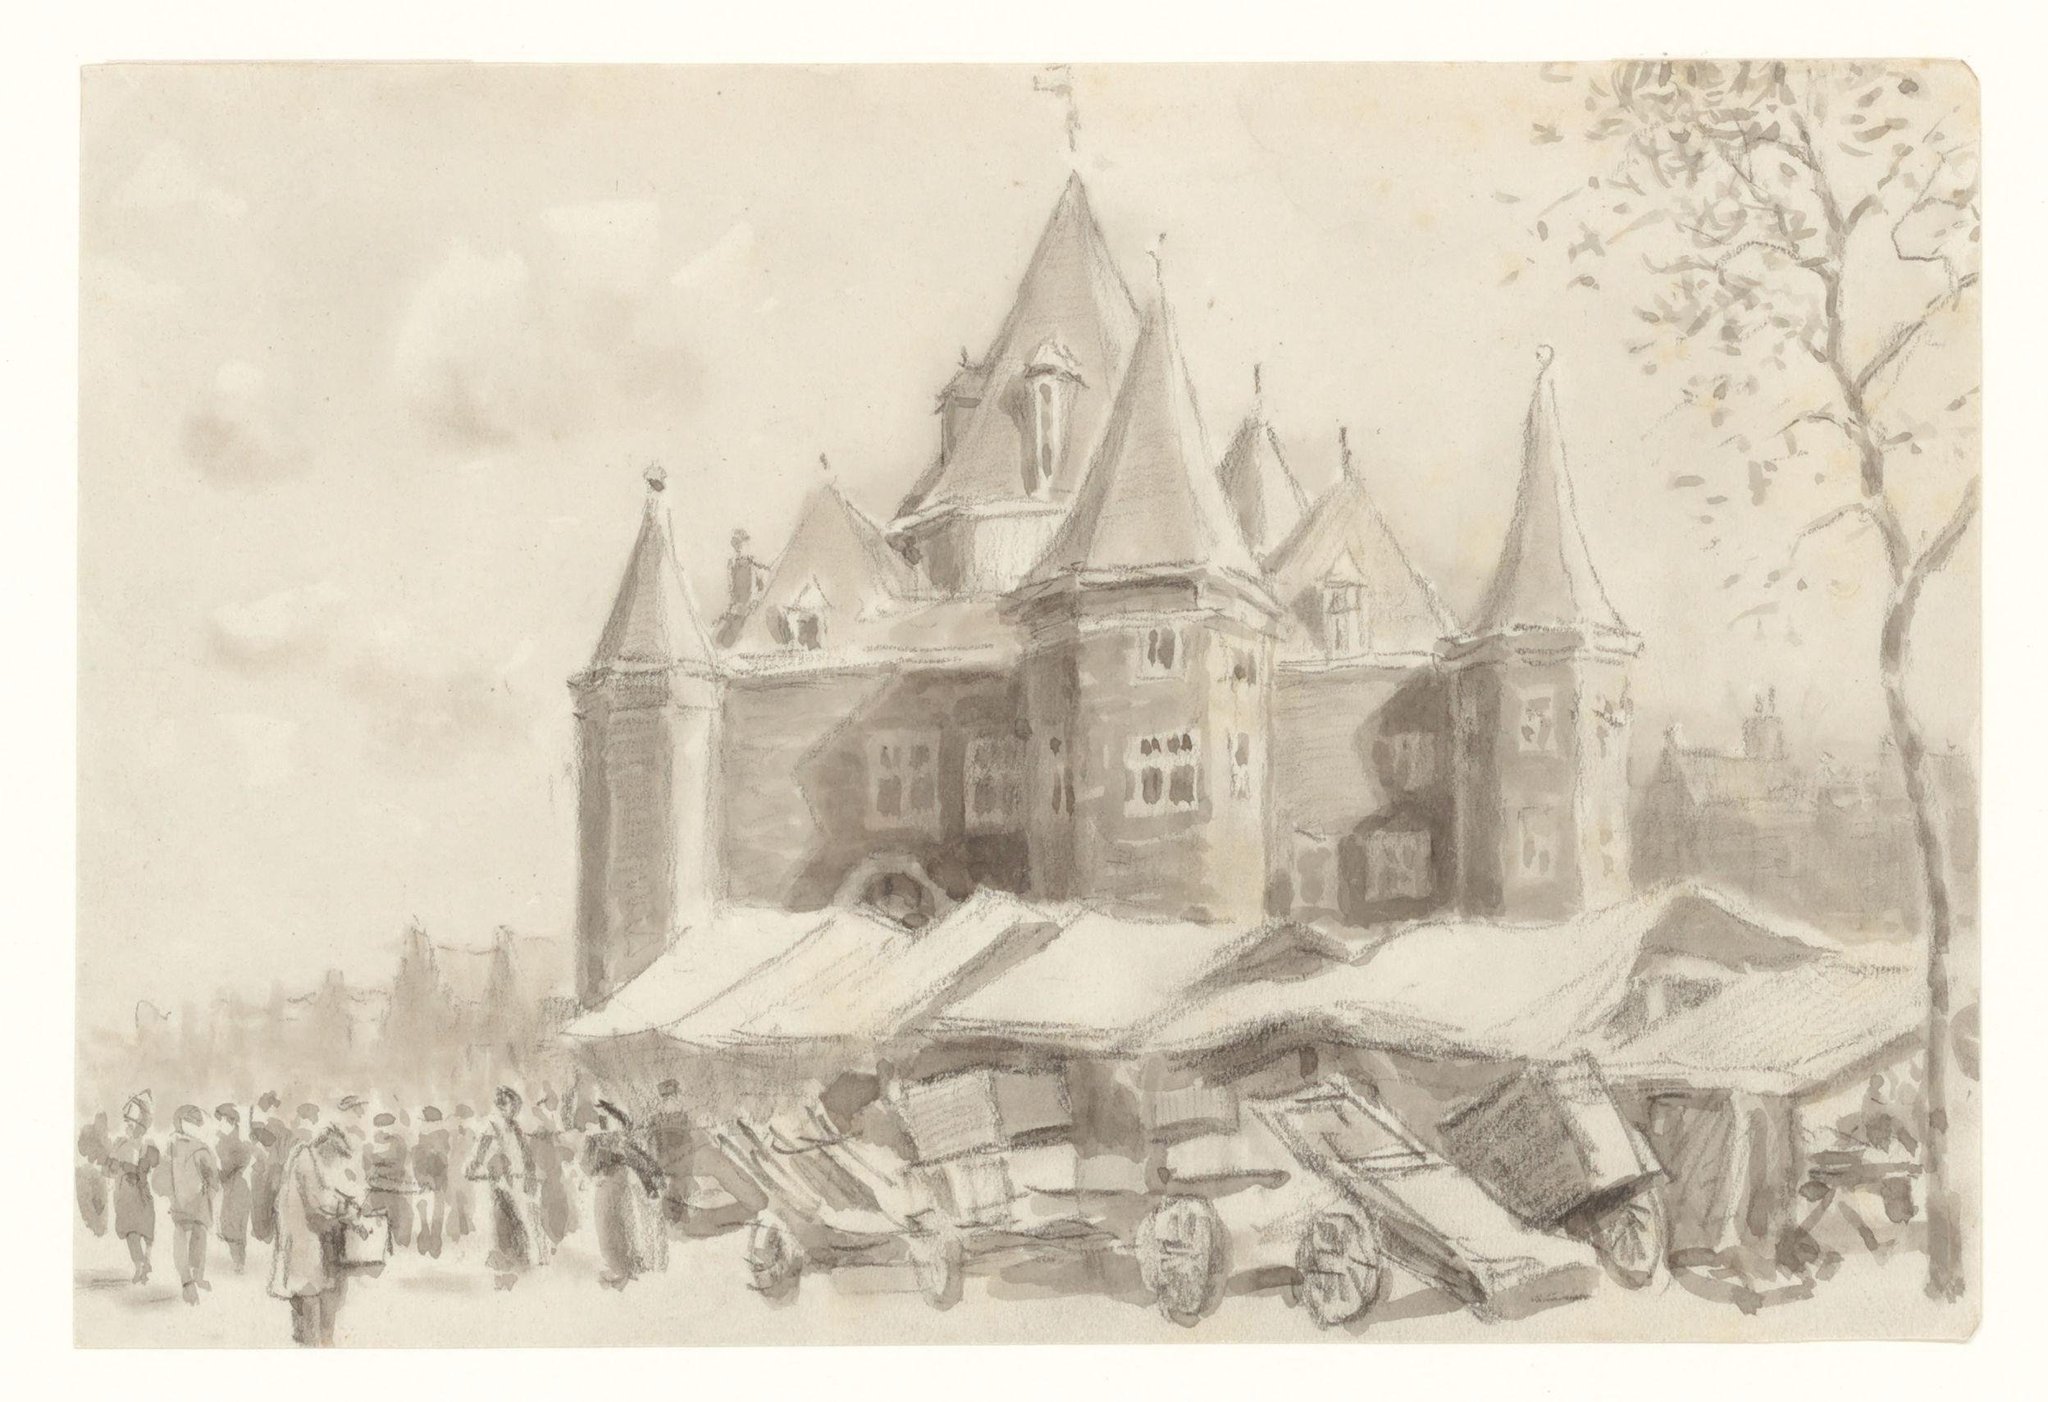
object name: drawing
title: Gezicht op de Waag op de Nieuwmarkt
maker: anthonie van teijn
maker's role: draughtsman, painter, print maker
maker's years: 1863-1943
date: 1873-1943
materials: chalk, ink, paper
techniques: brush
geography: amsterdam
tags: square, place, circus, etc., city-view in general; 'veduta', weigh-house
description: Tekening binnen de Atlas Van Eck ingedeeld op wijknummer 10.